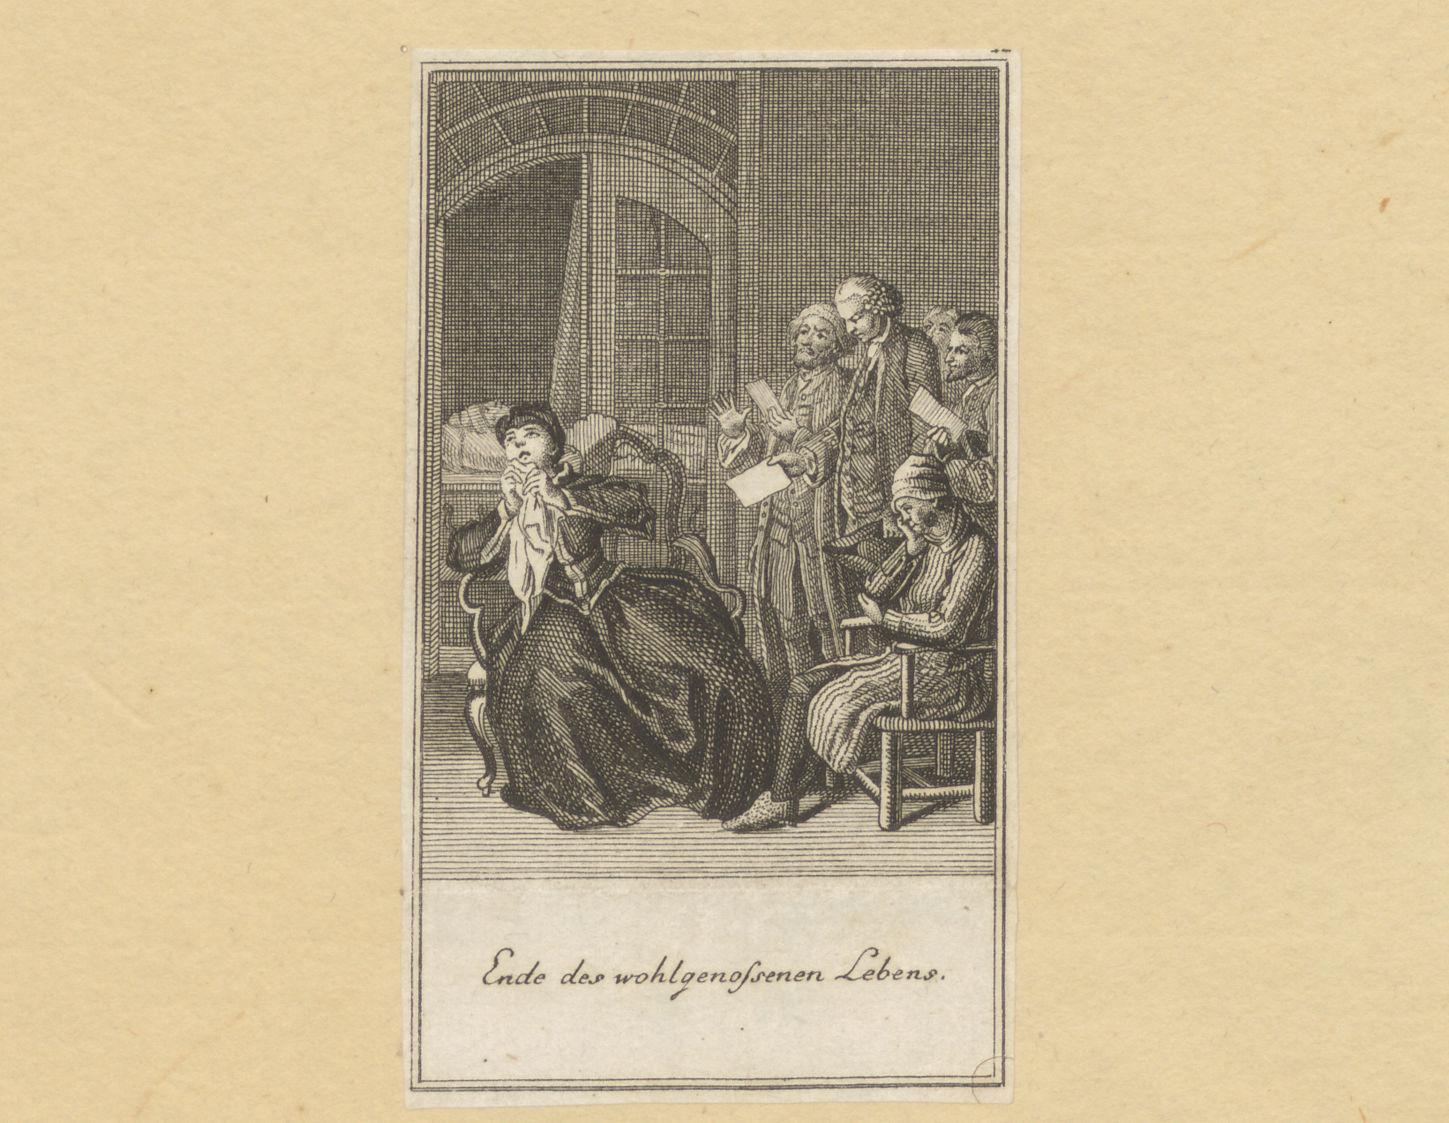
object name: print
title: Ende des wohlgenossenen Lebens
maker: daniel berger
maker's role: print maker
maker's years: 1744-1824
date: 1773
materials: paper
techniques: etching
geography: berlin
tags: deathbed, mourning the dead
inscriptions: collector's mark: Lugt 2228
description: Prent afkomstig uit: Genealogischer Calender auf das Jahr 1774. Mit Genehmigung der Königlichen Academie der Wissenschaften zu Berlin herausgegeben. Twaalfde scène uit de serie 'Das Leben eines Lüderlichen', bestaand uit twaalf scènes, gedrukt van een koperplaat.